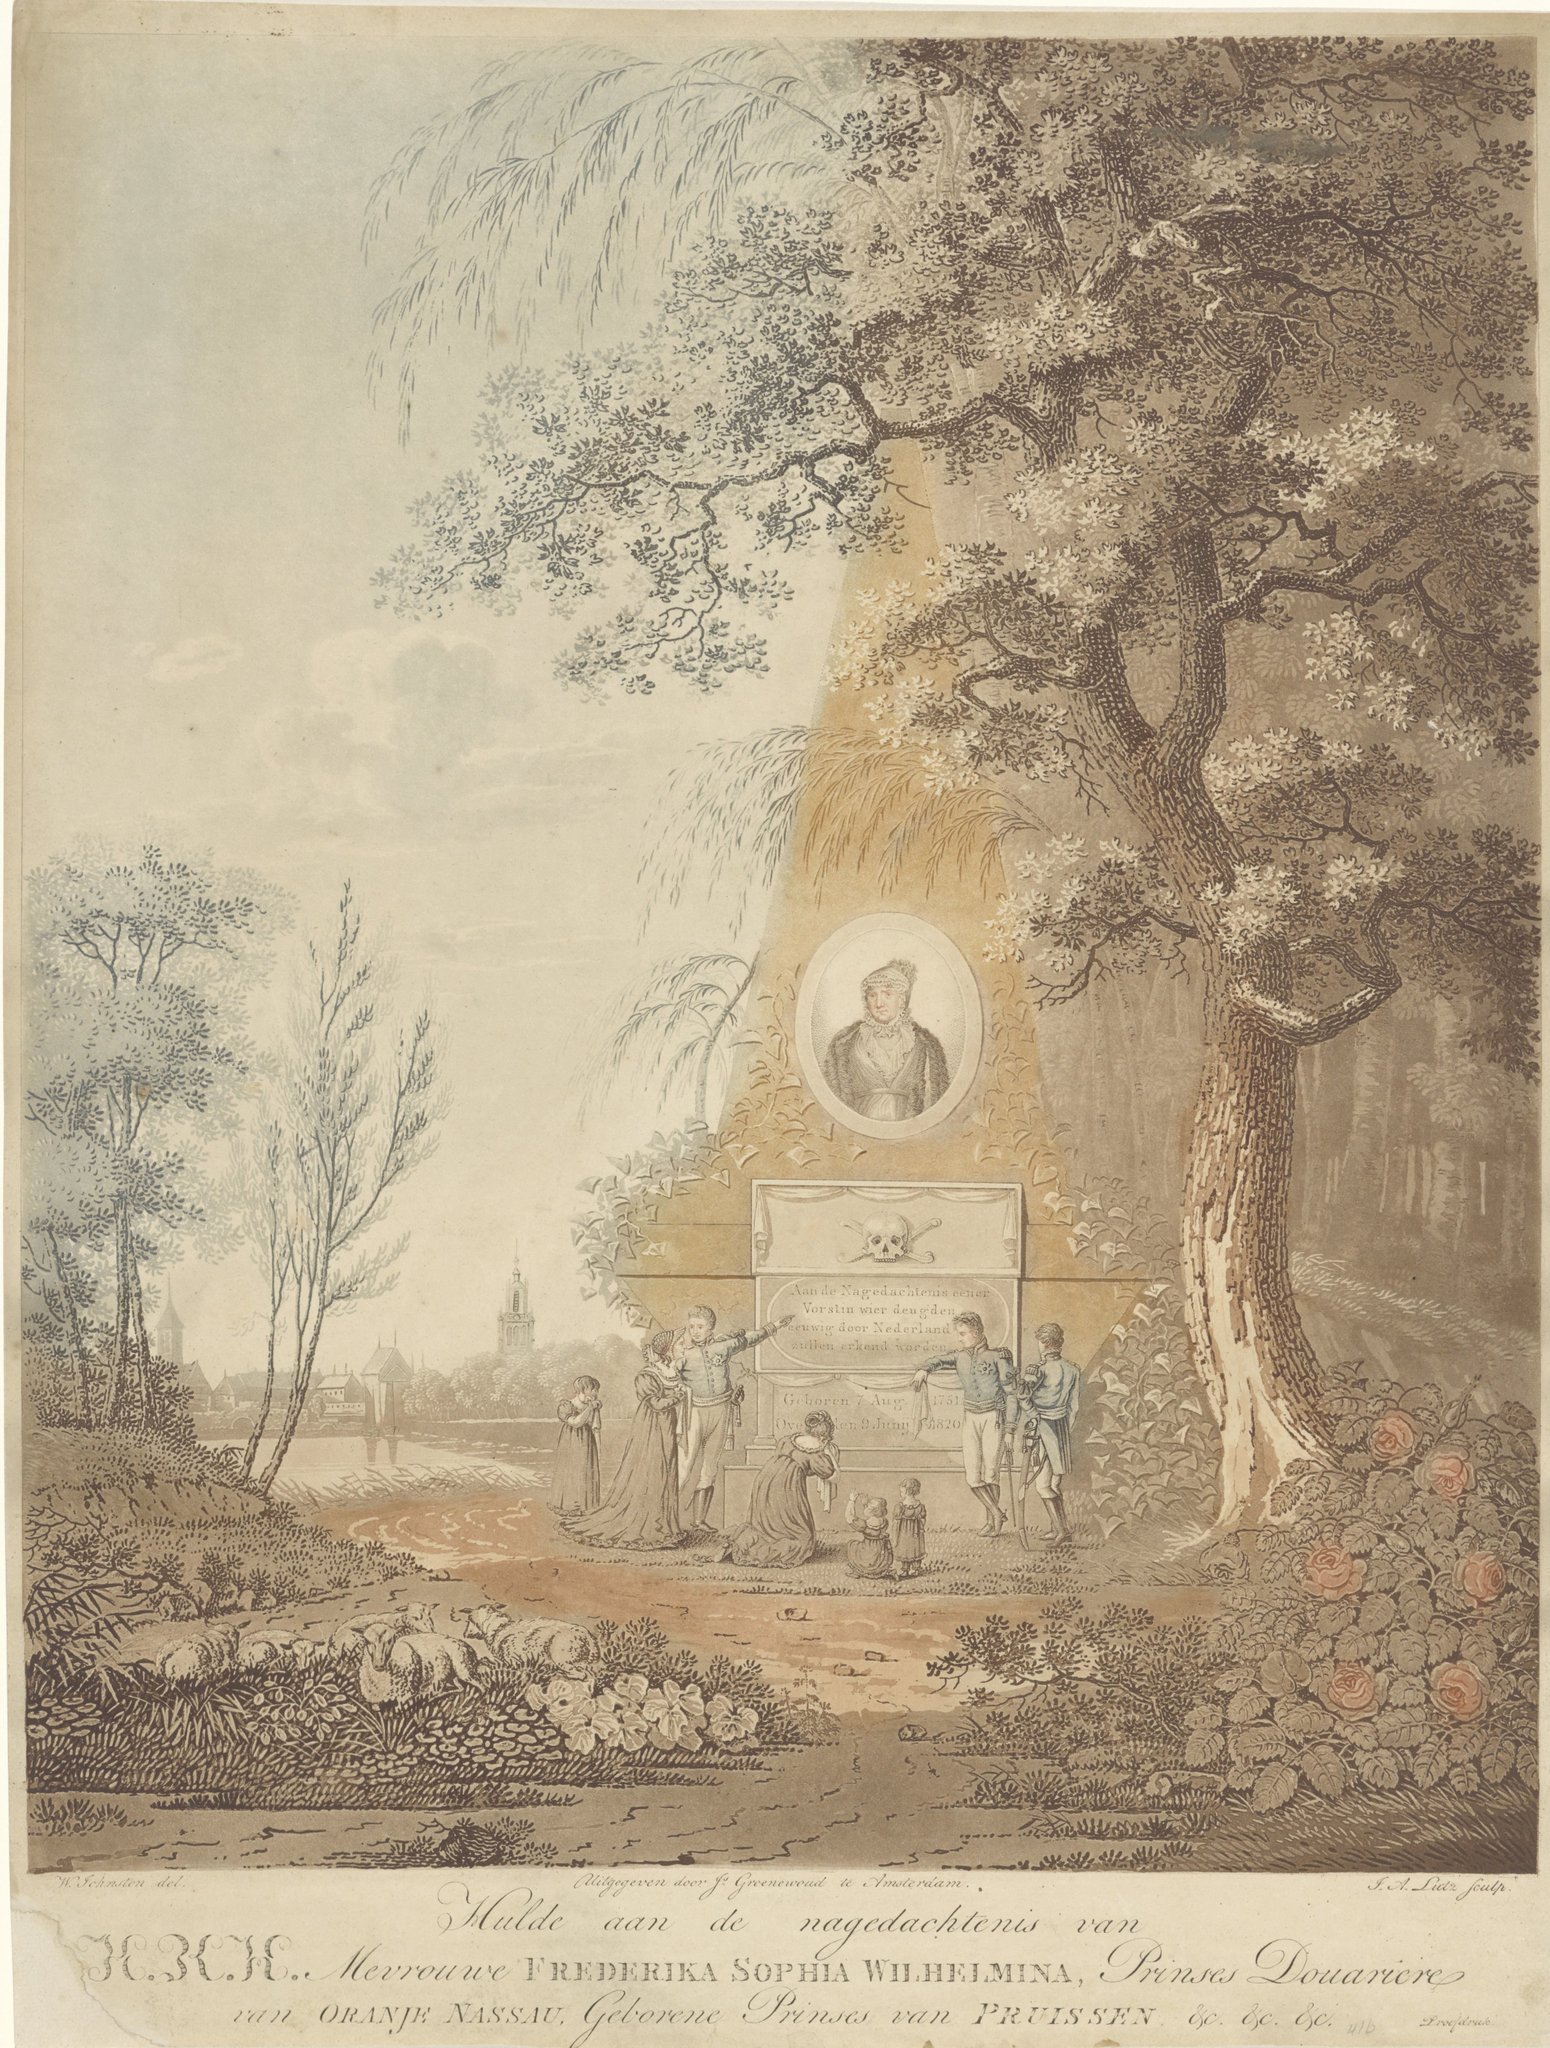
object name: print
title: Gedenknaald ter gelegenheid van het overlijden van Wilhelmina van Pruisen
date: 1822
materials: paper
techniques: aquatint, etching, lithography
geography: the hague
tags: berlin, painter, draughtsman, wilhelmina of prussia (princess of orange), obelisk, needle